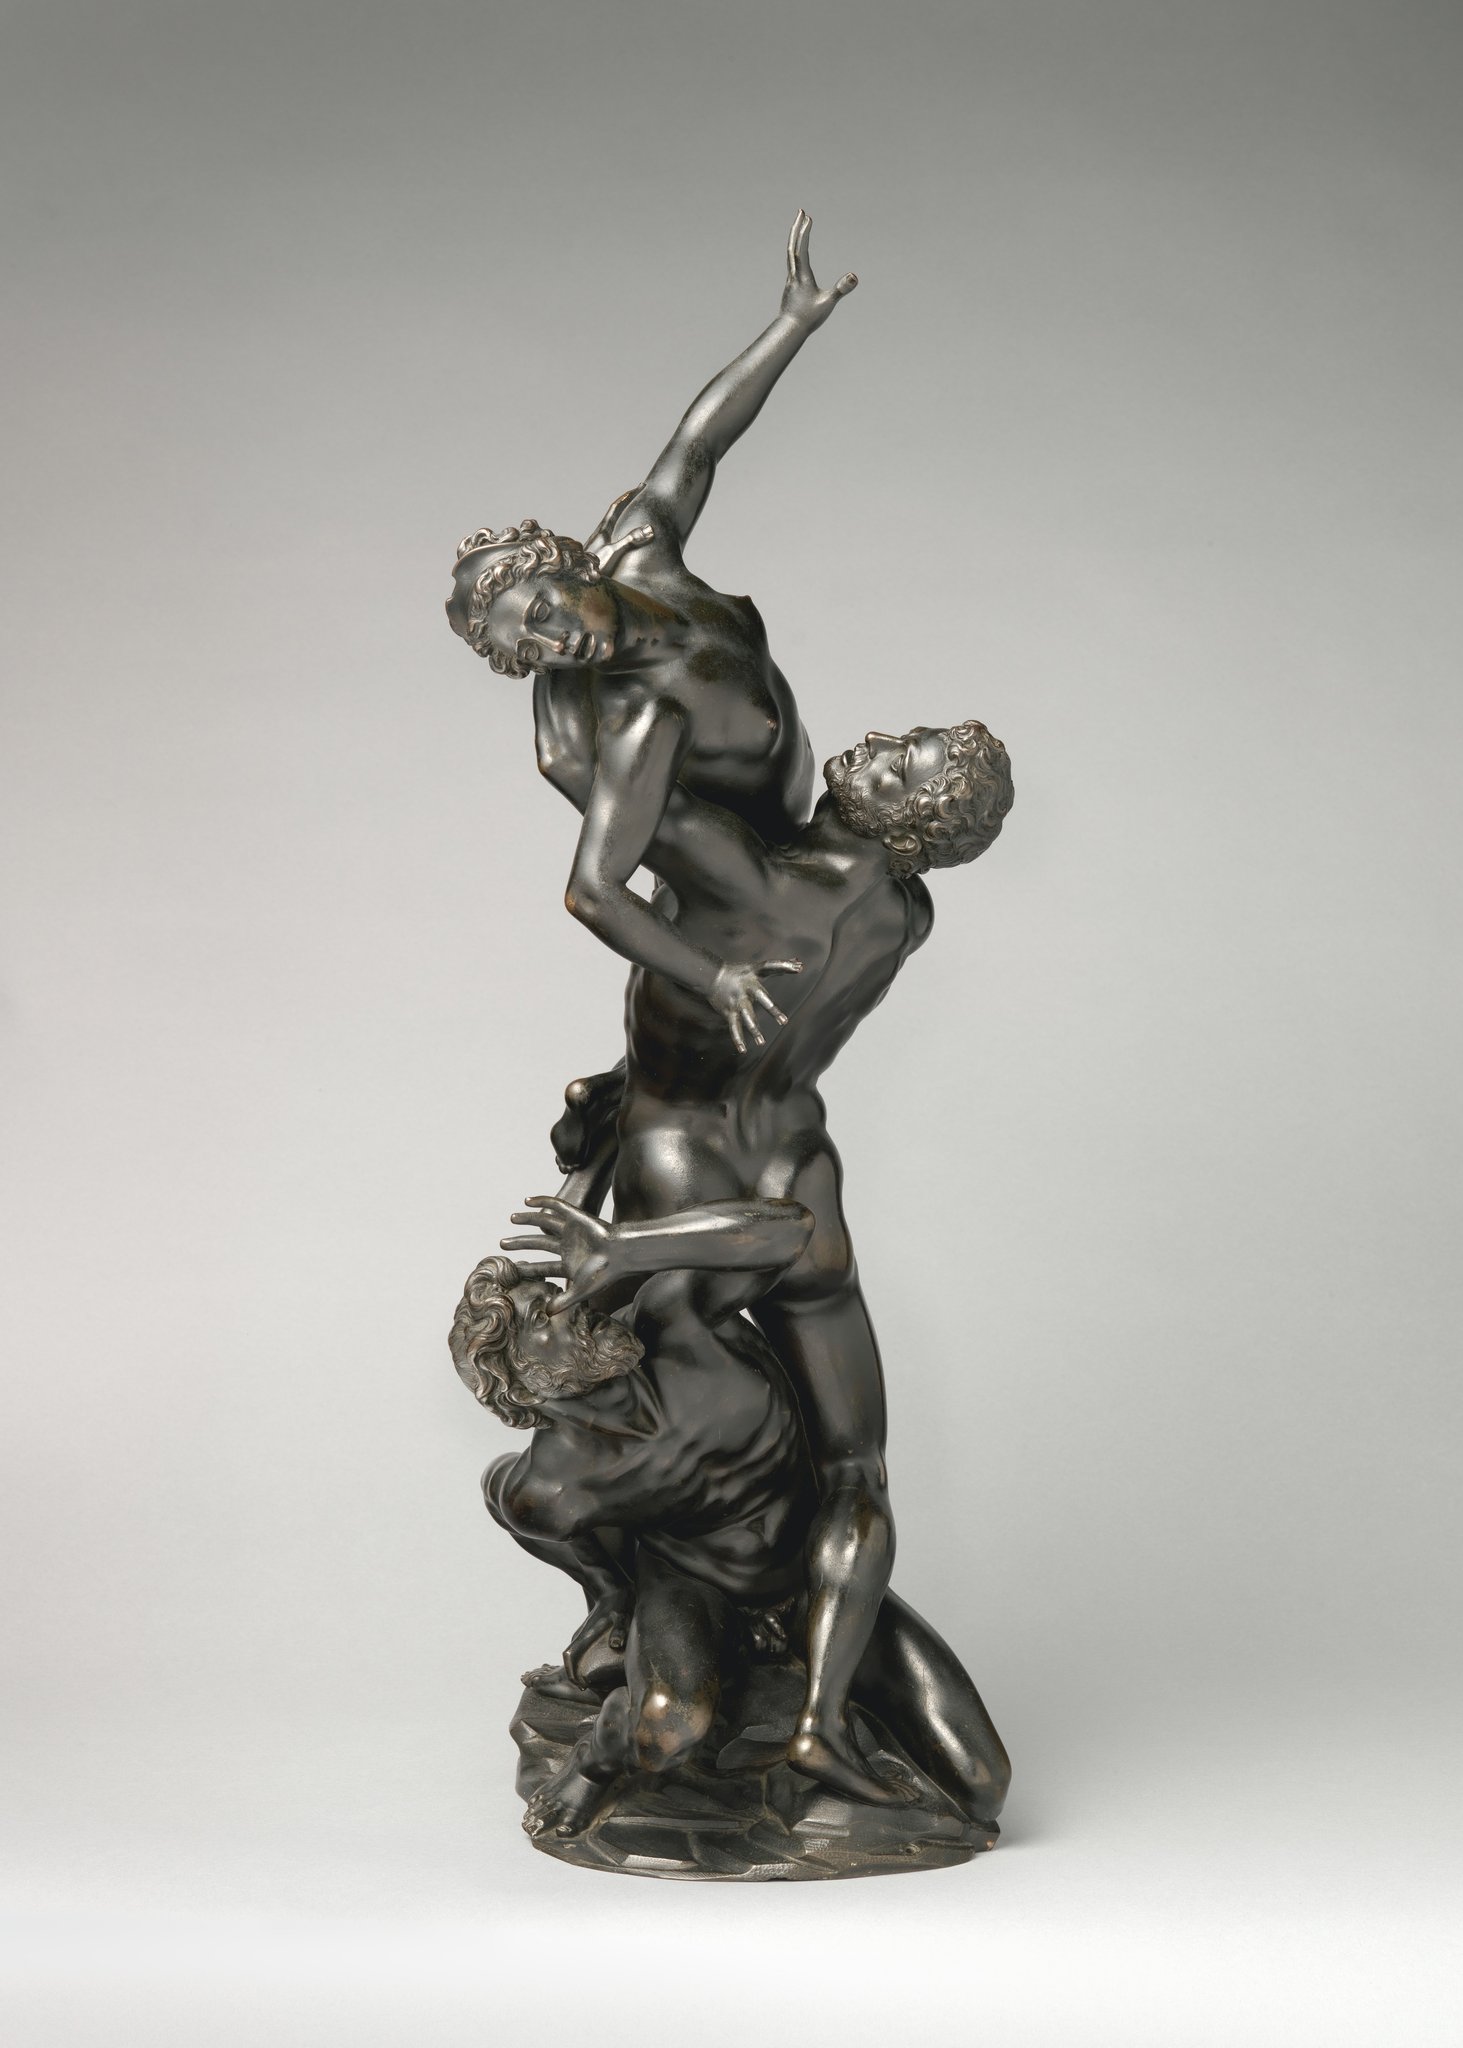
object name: statuette group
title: Abduction of a Sabine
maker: giambologna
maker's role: artist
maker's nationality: netherlandish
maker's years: 1529-1608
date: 1701-1800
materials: bronze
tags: male nudes,female nudes